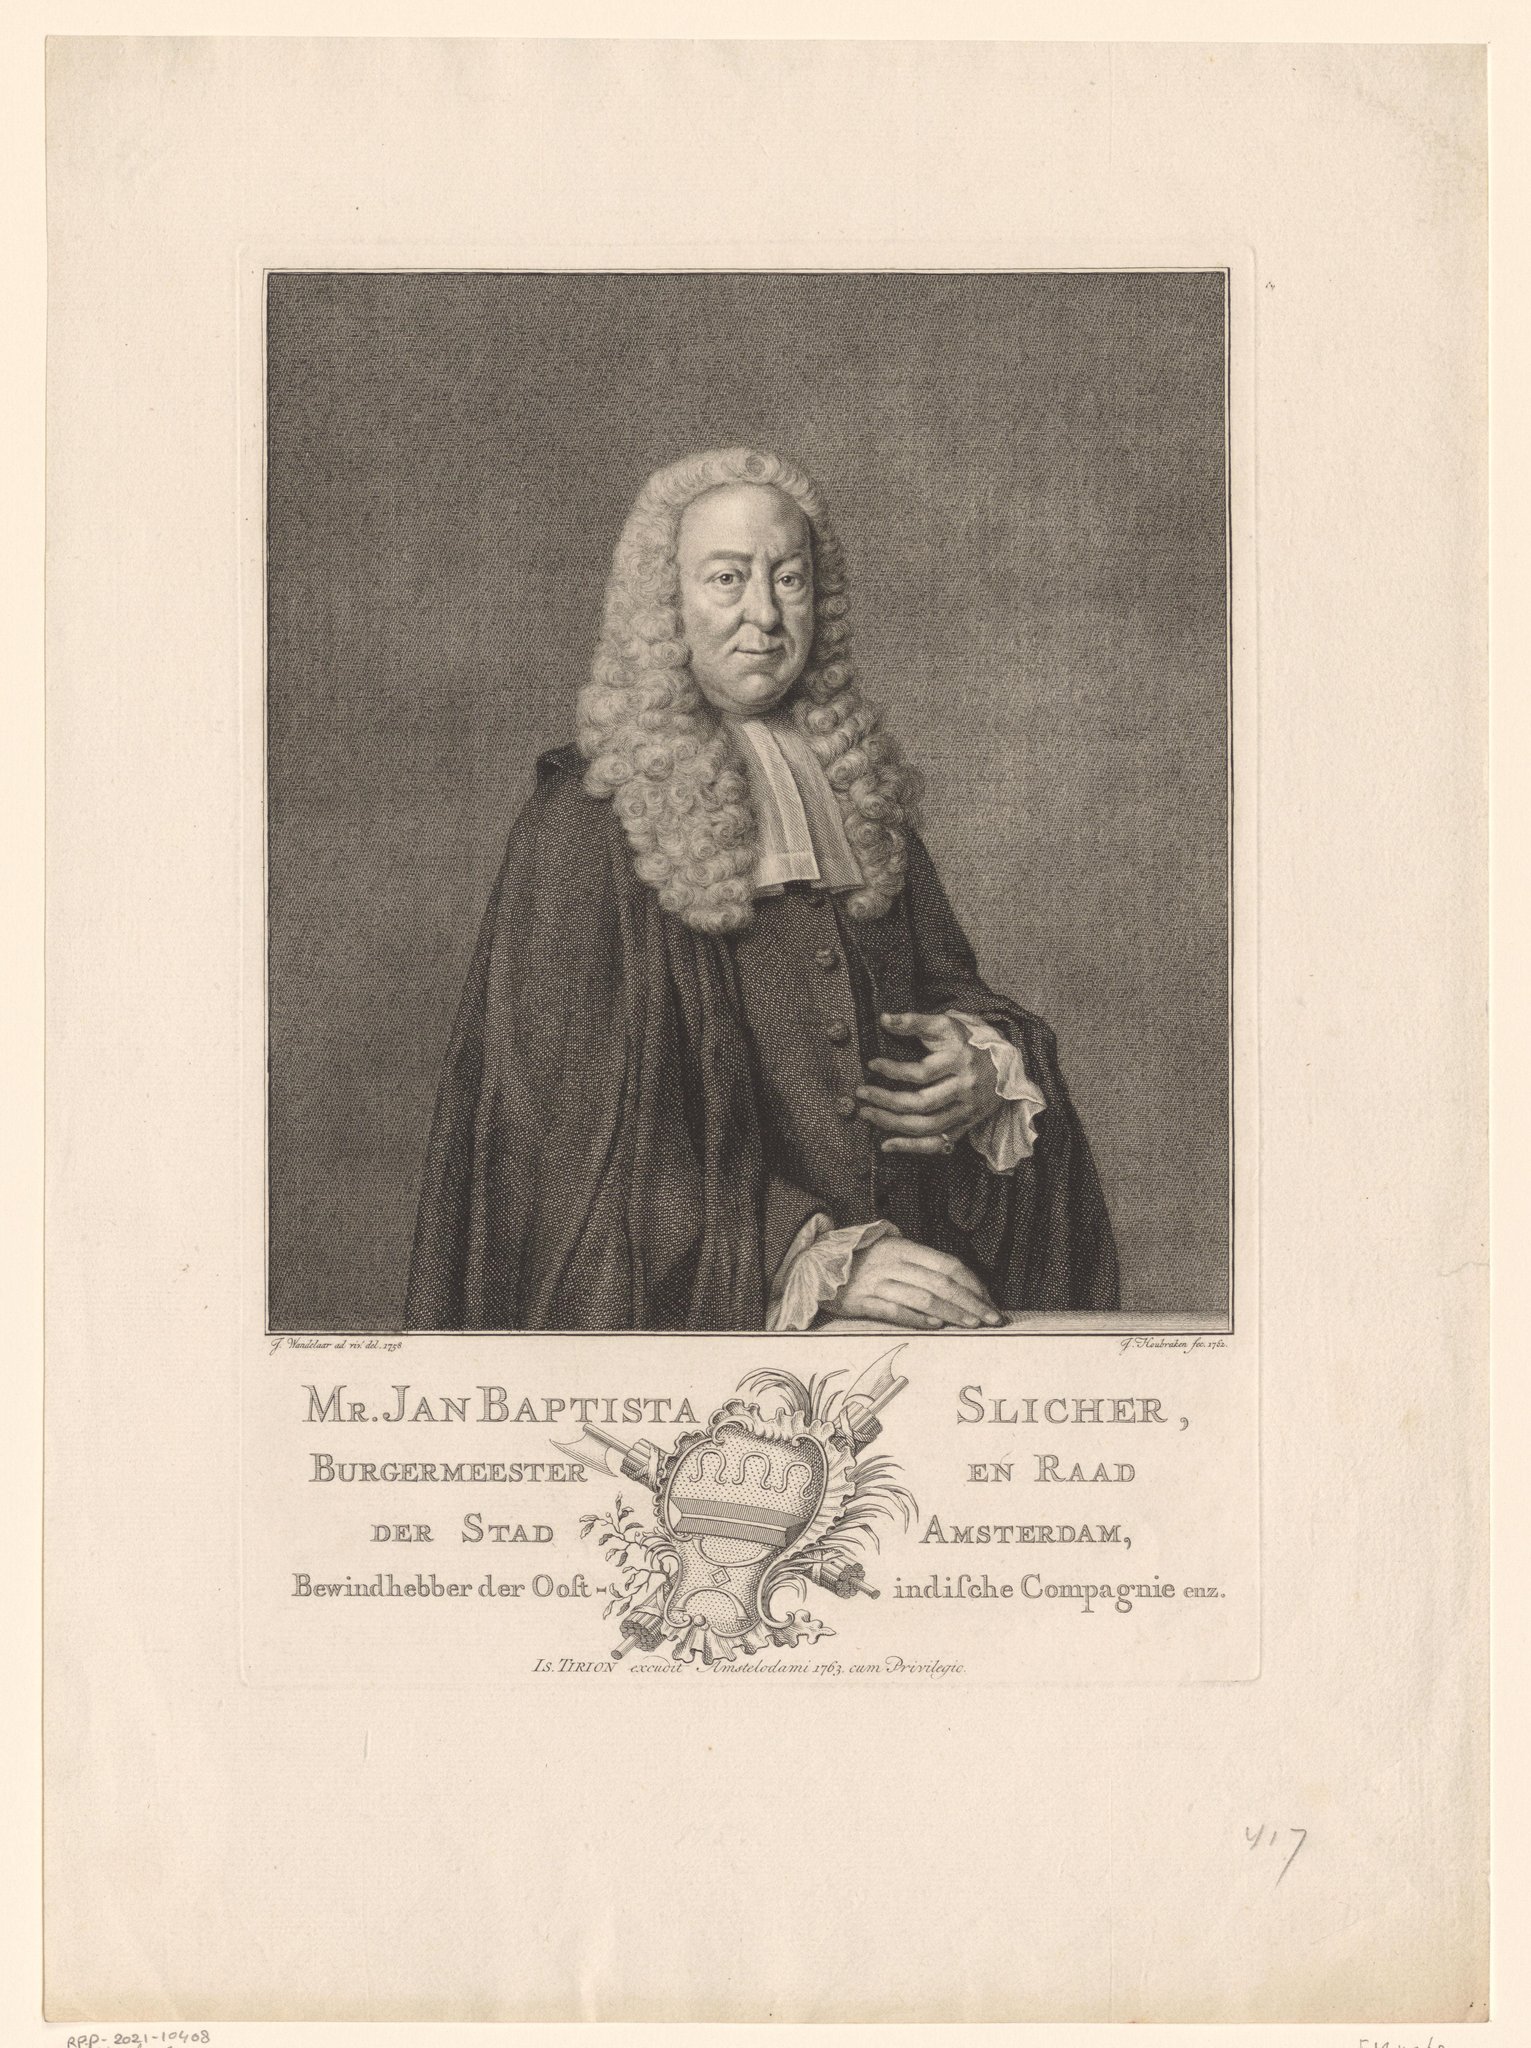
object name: print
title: Portret van Jan Baptista Slicher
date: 1763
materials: paper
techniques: engraving, etching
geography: amsterdam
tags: adult man, historical persons, armorial bearing, heraldry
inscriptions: collector's mark: Lugt 2228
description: Portret van Jan Baptista Slicher ten halve lijve naar rechts. Onder het portret zijn naam en gegevens in vier regels in het Nederlands en zijn familiewapen met fasces.